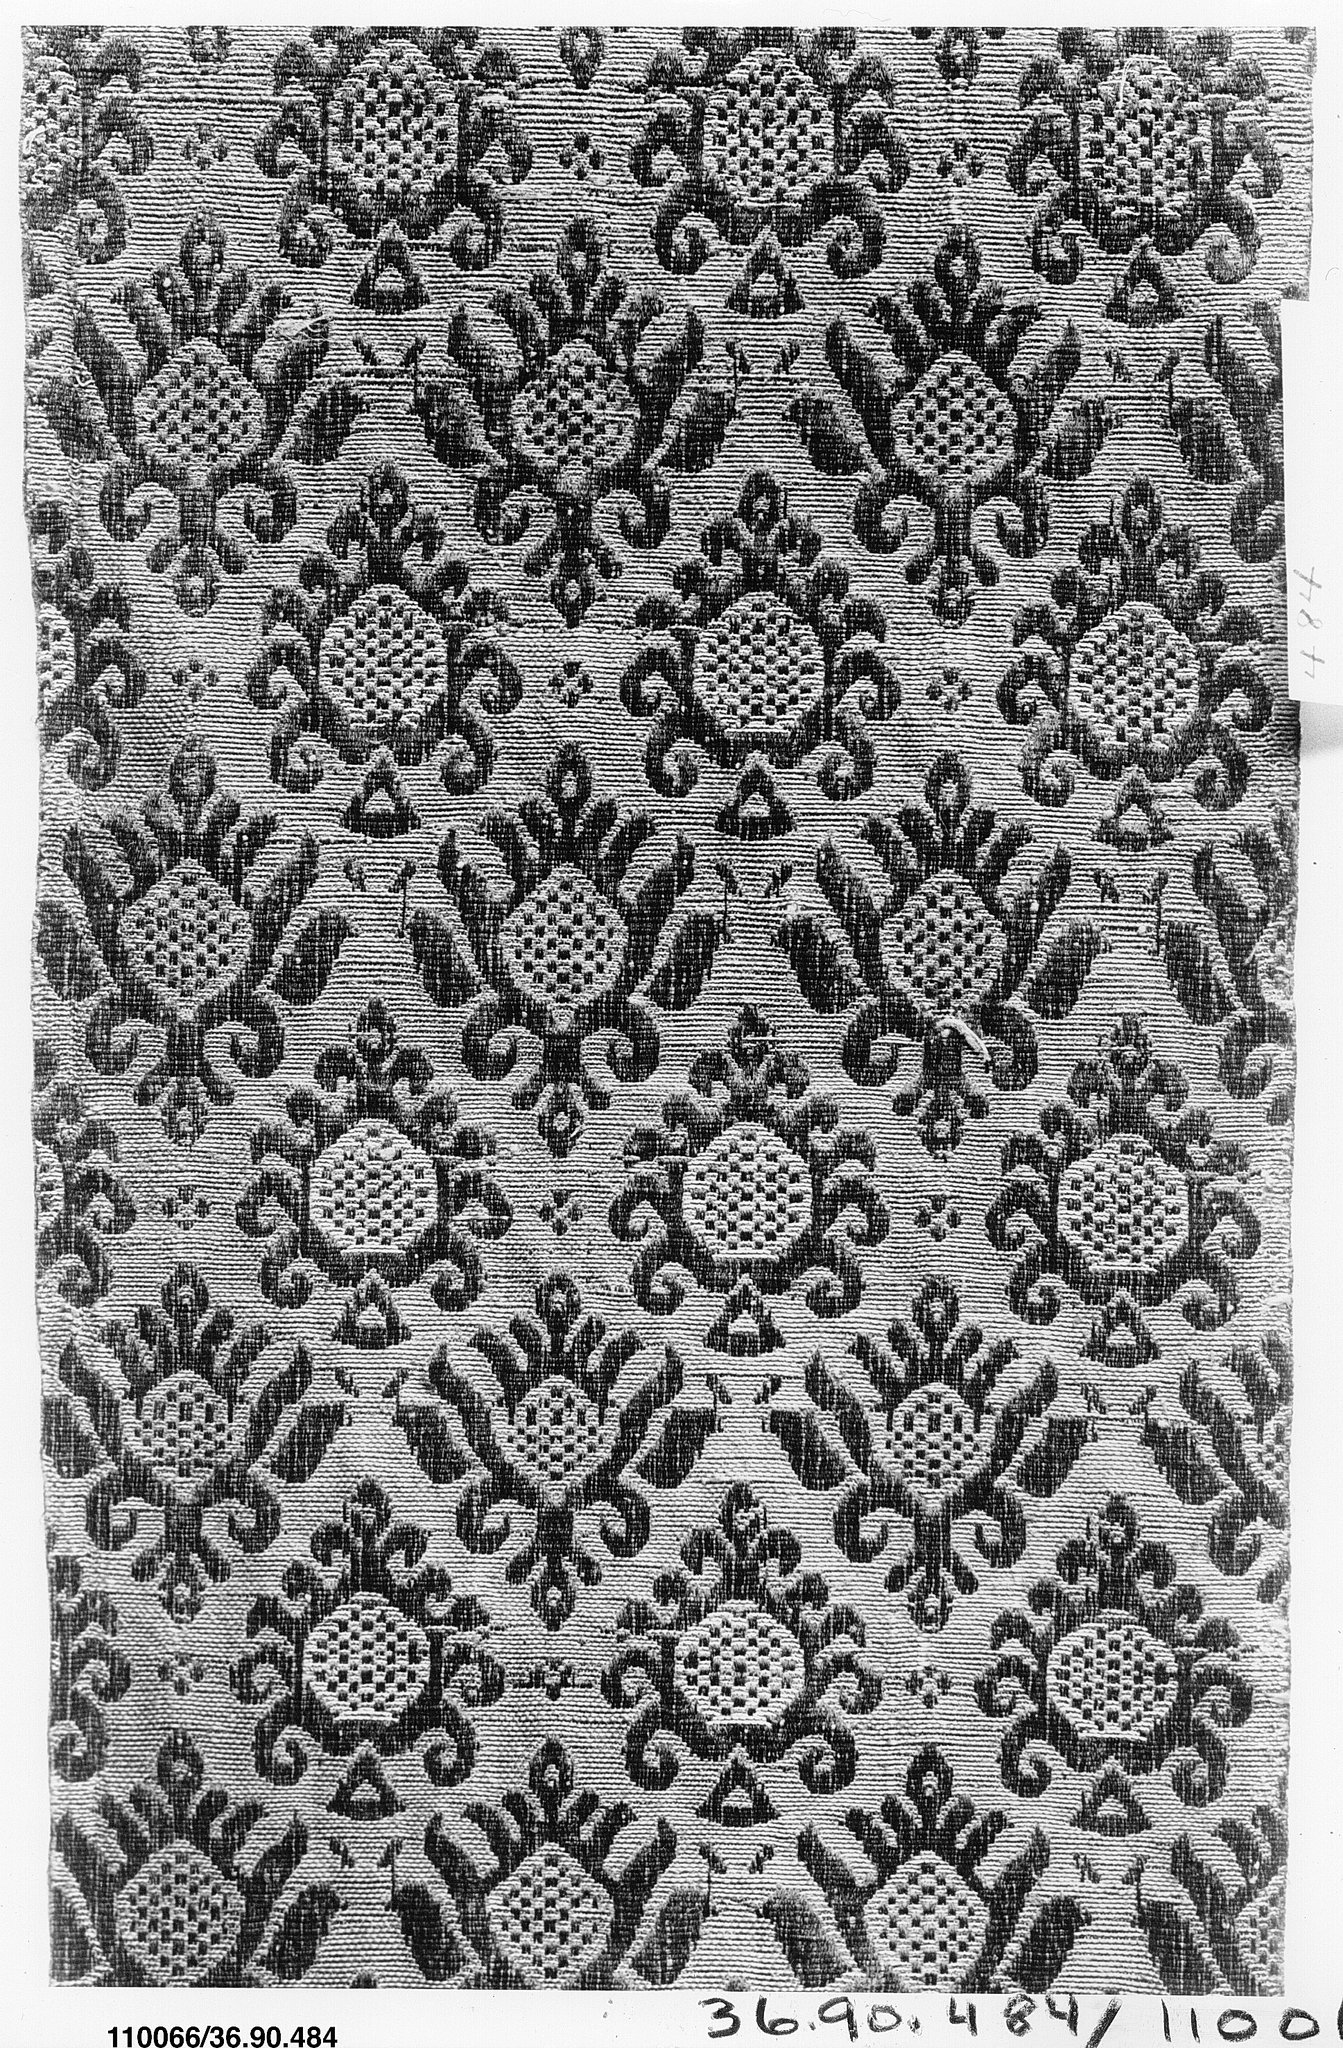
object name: piece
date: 1501-1600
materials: linen, silk